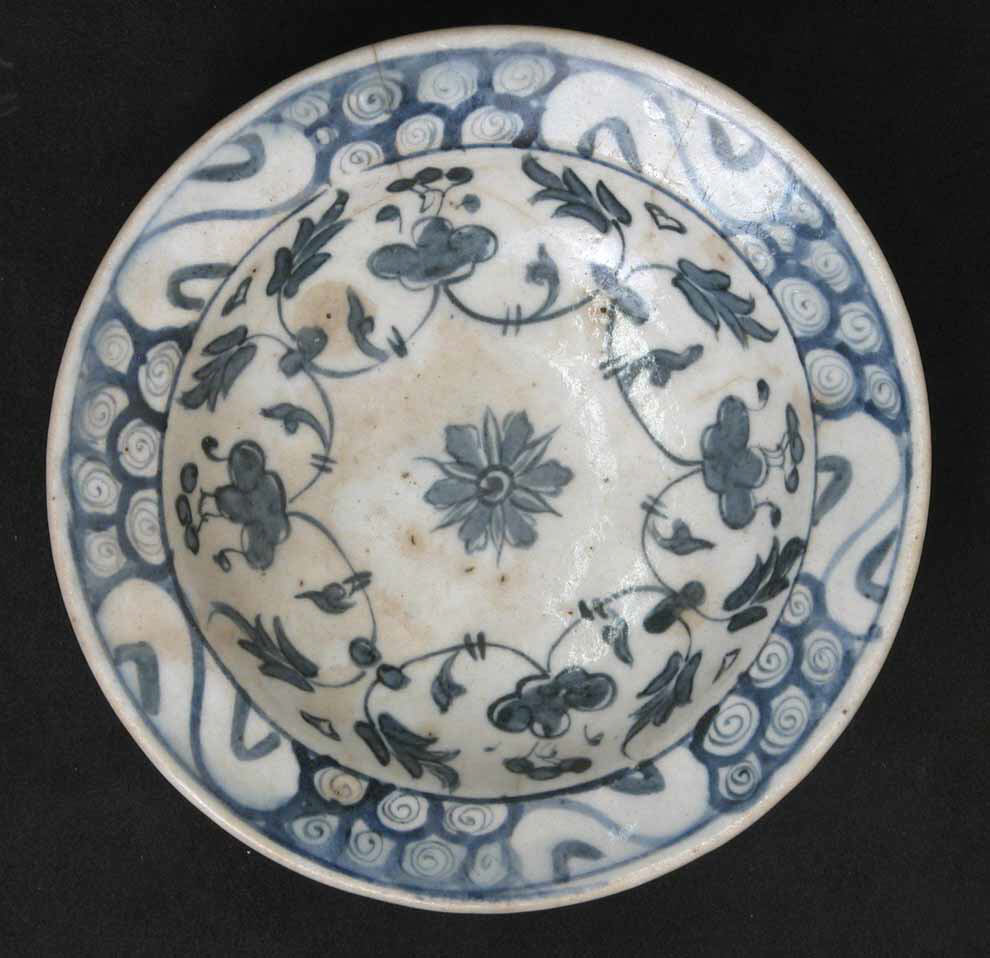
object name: bowl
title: Footed Bowl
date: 1501-1600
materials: glaze, stonepaste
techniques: painting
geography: turkey